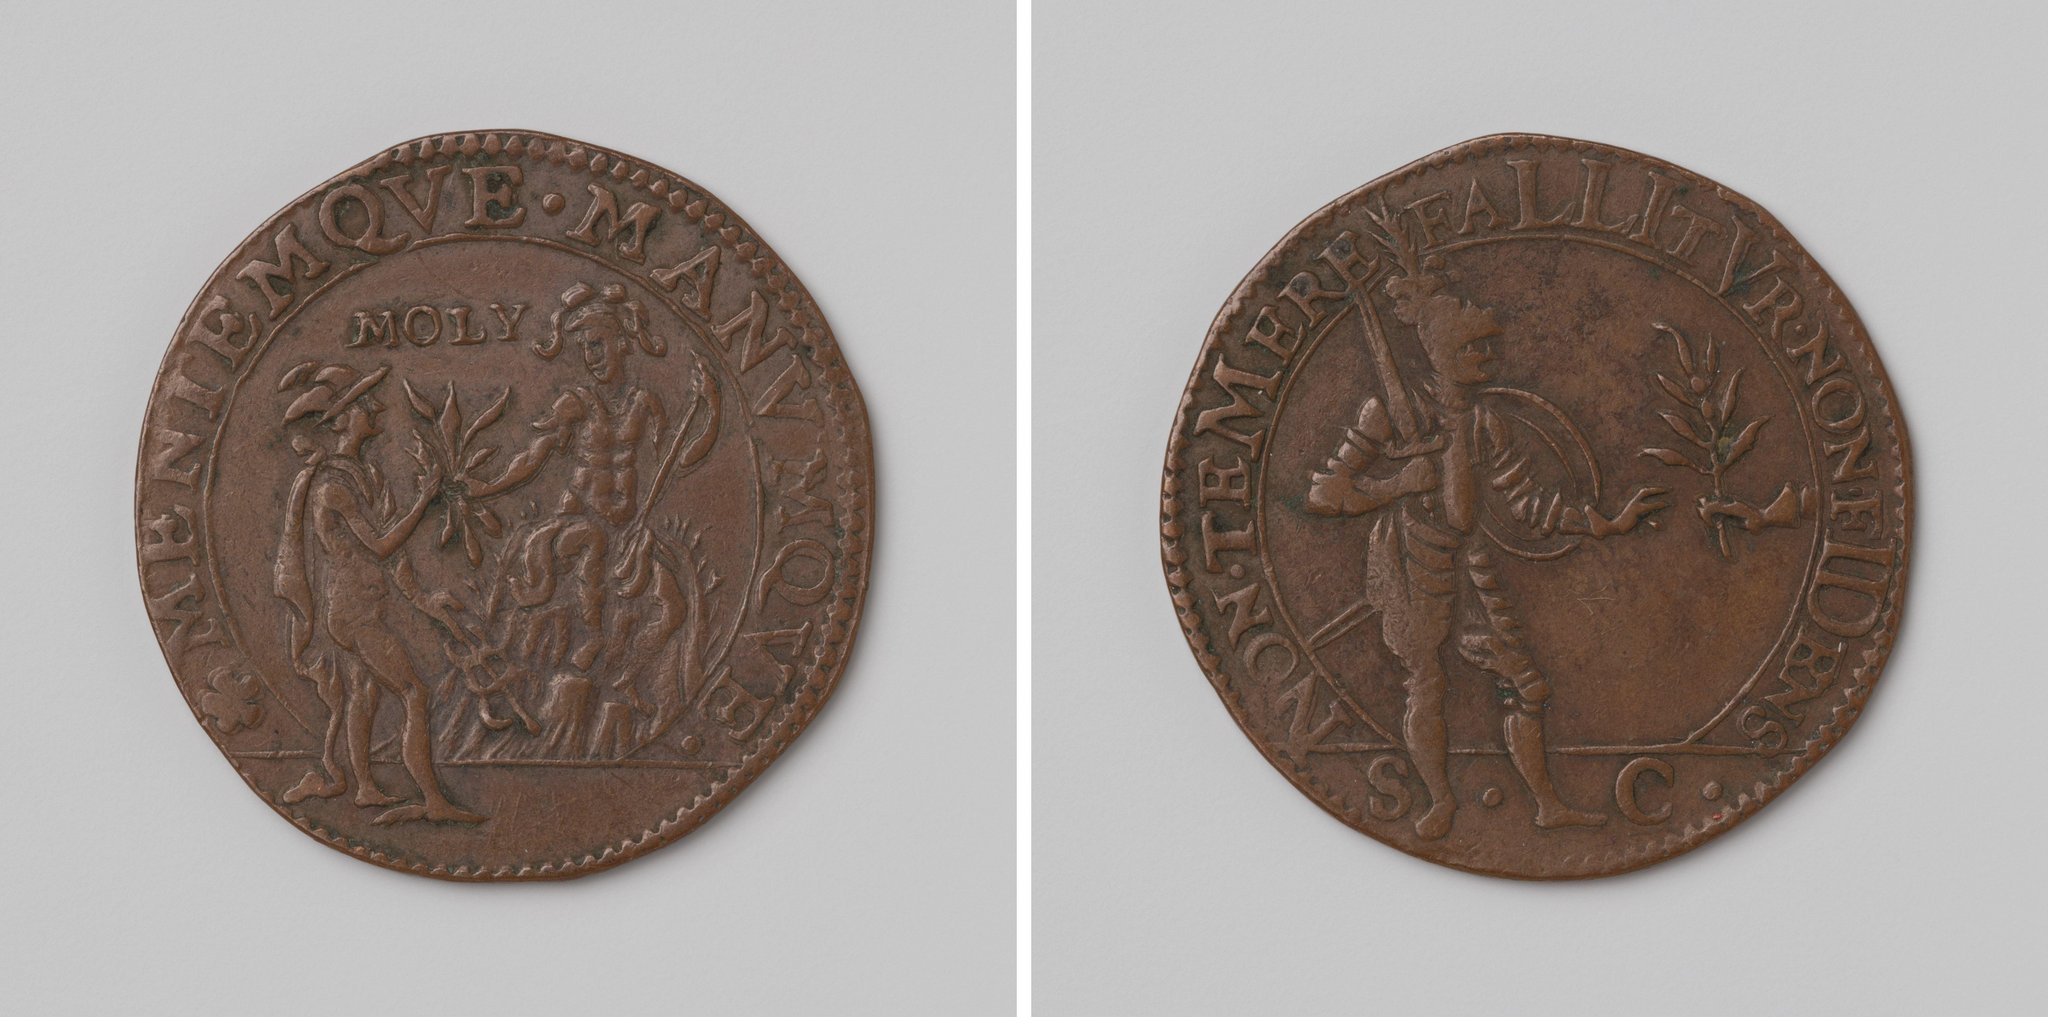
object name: jeton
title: Allegorische waarschuwing tegen de Spaanse vredesvoorstellen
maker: Anonymous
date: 1607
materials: copper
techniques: striking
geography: dordrecht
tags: the hague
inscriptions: circumscription: ‘NON TEMERE FALLITVR NON FIDENS / S C’, circumscription: ‘MENTEMEQVE MANVMQVE’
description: Koperen penning. Voorzijde: Mercurius met gevleugelde helm en staf overhandigt Odysseus kruid, waarmee hij de verlokkingen van Cyrce kan weerstaan onder opschrift binnen omschrift. Keerzijde: hand biedt gewapende man een vredestak aan binnen omschrift; afsnede: monogram S.C.